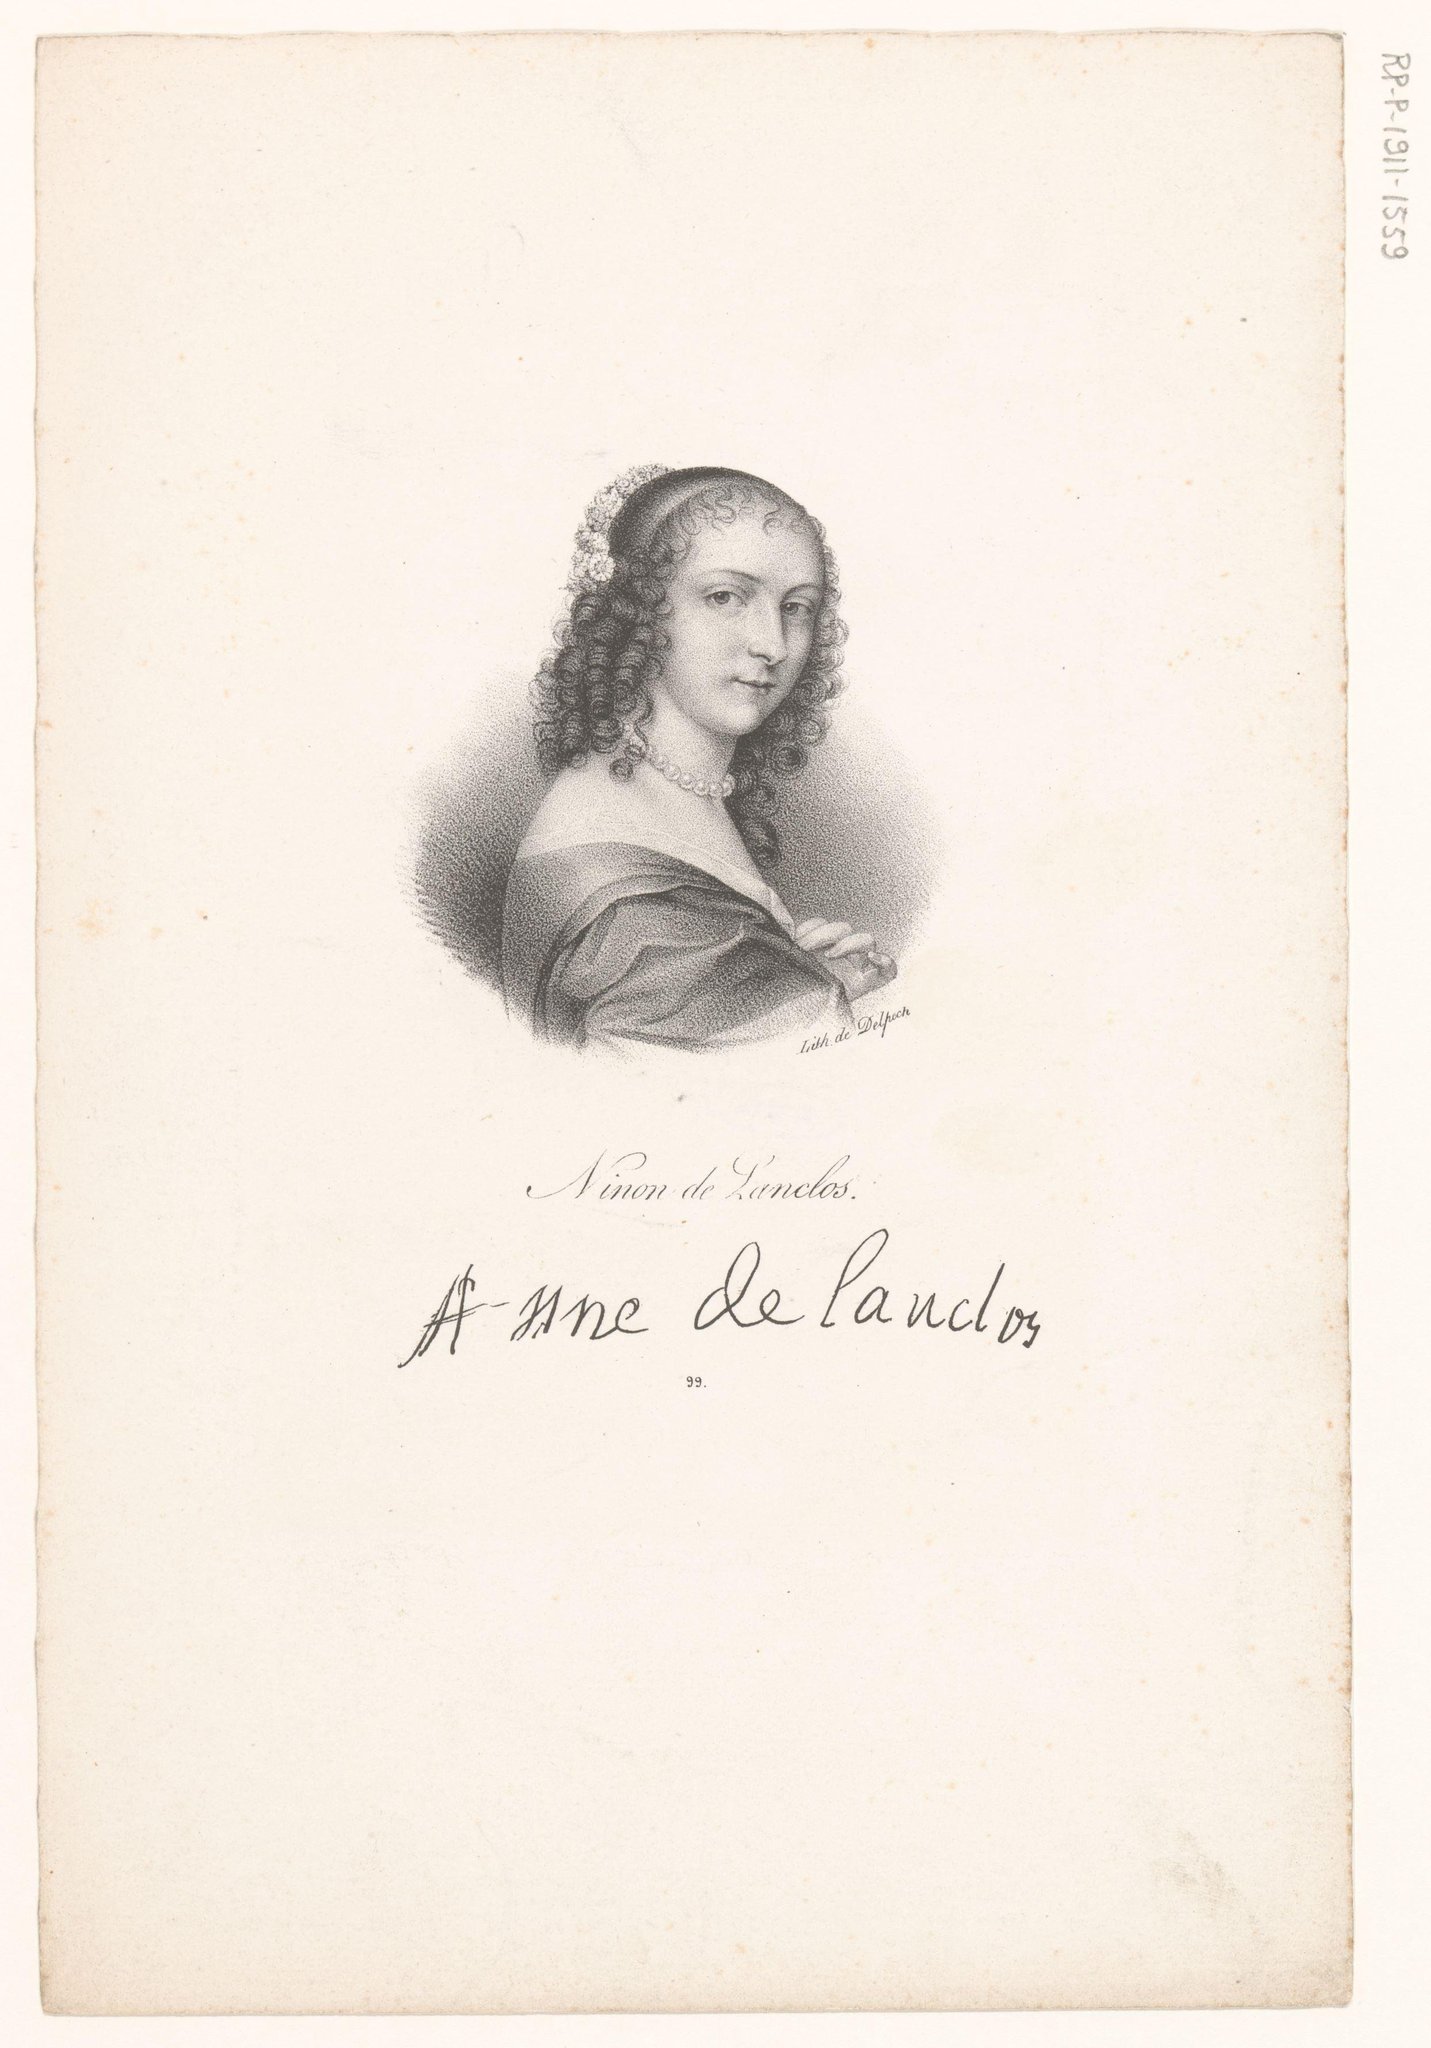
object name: print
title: Portret van Ninon de Lenclos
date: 1818-1842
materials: paper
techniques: lithograph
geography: paris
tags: paris, historical persons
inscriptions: collector's mark: Lugt 2228a